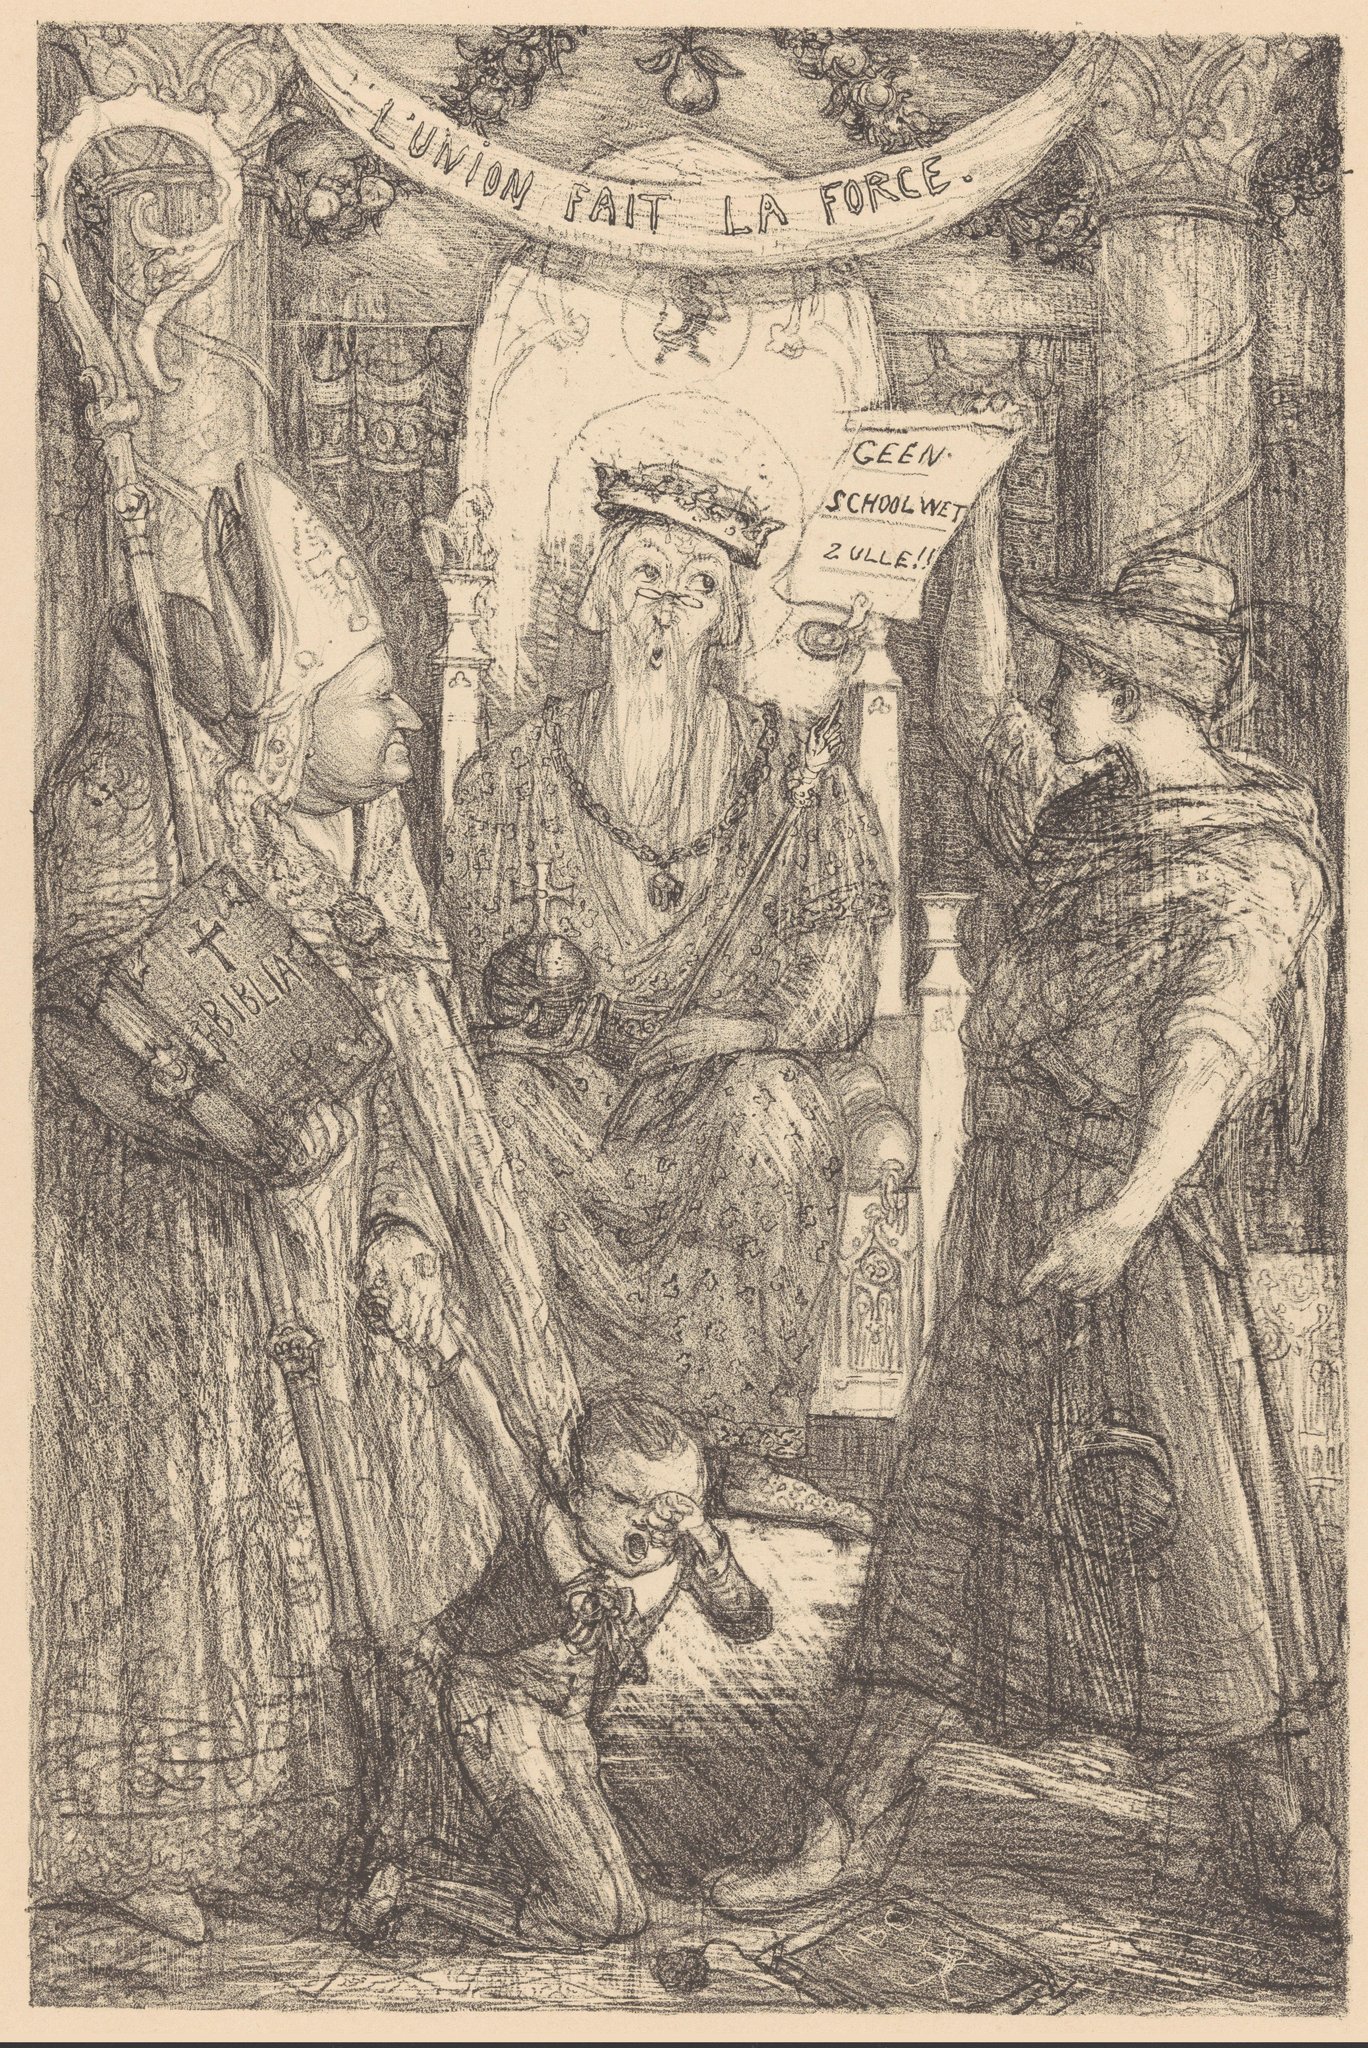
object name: cartoon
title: Uit den schoolwet-strijd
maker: marius bauer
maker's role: draughtsman, print maker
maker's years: 1867-1932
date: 1895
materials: paper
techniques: lithograph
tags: political caricatures and satires, belgium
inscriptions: collector's mark: Lugt 2228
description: Spotprent op de schoolstrijd in België in 1895. Pastiche op het oordeel van koning Salomo die moet kiezen tussen de kerk als voorstander en de liberale tegenstander van de schoolwet, in het midden een huilend schoolkind. Verschenen in het bijvoegsel van 'De Kroniek' van 4 augustus 1895.